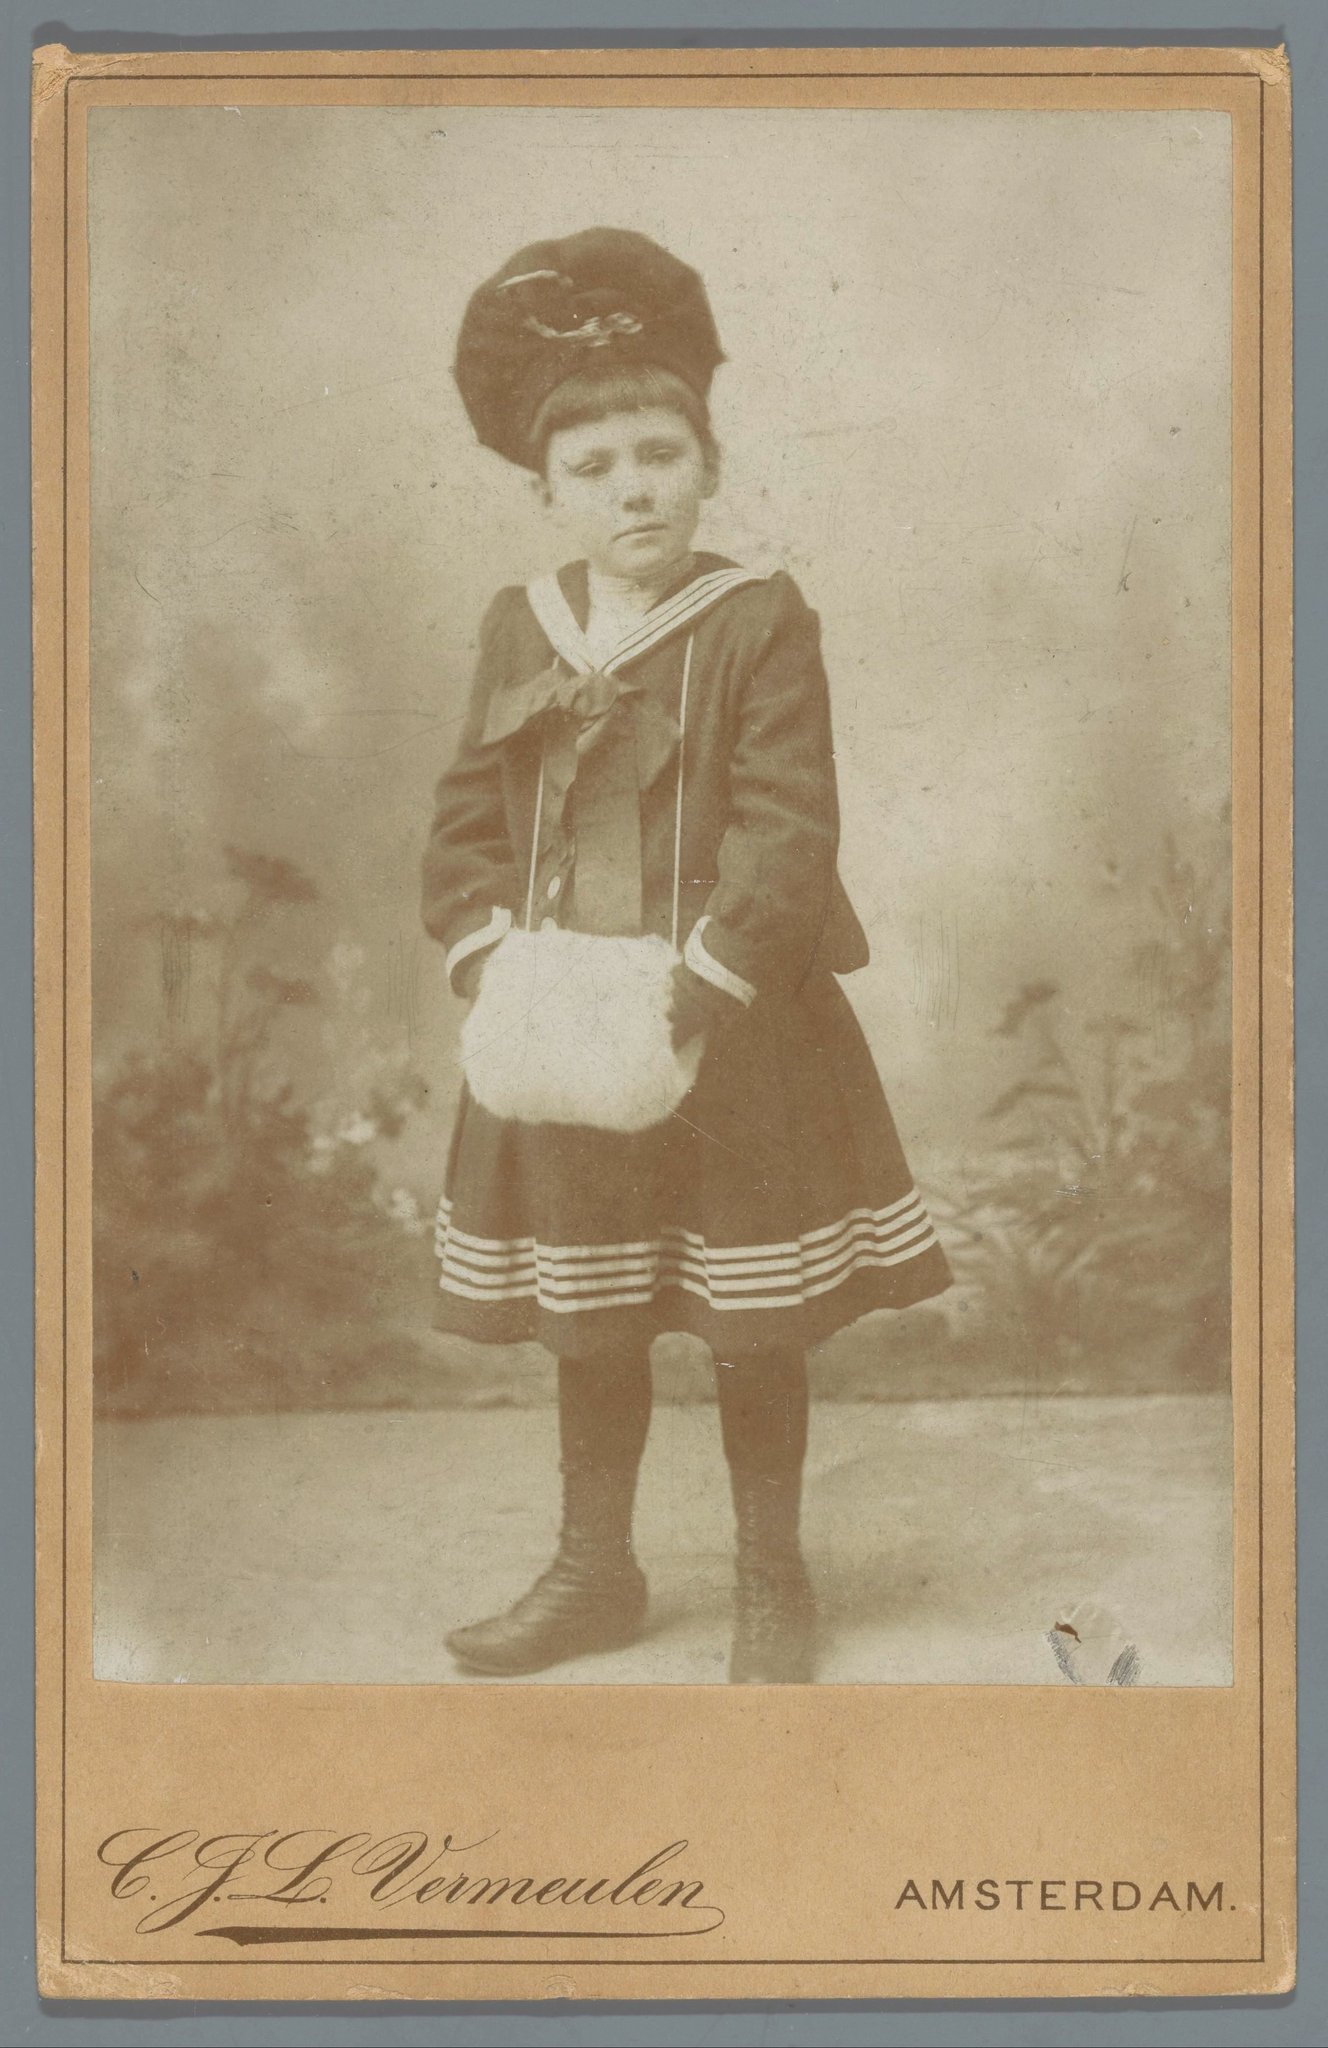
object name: cabinet photograph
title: Studioportret van een onbekend meisje met een mof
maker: cornelis johannes lodewicus vermeulen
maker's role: fotograaf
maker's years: 1861-1936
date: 1890-1915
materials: paper, photographic support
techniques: gelatin silver print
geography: amsterdam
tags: sleeves, girl (child between toddler and youth)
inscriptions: inscription: ‘Photographische Ateliers (...) Specialiteit in vergrootingen.’